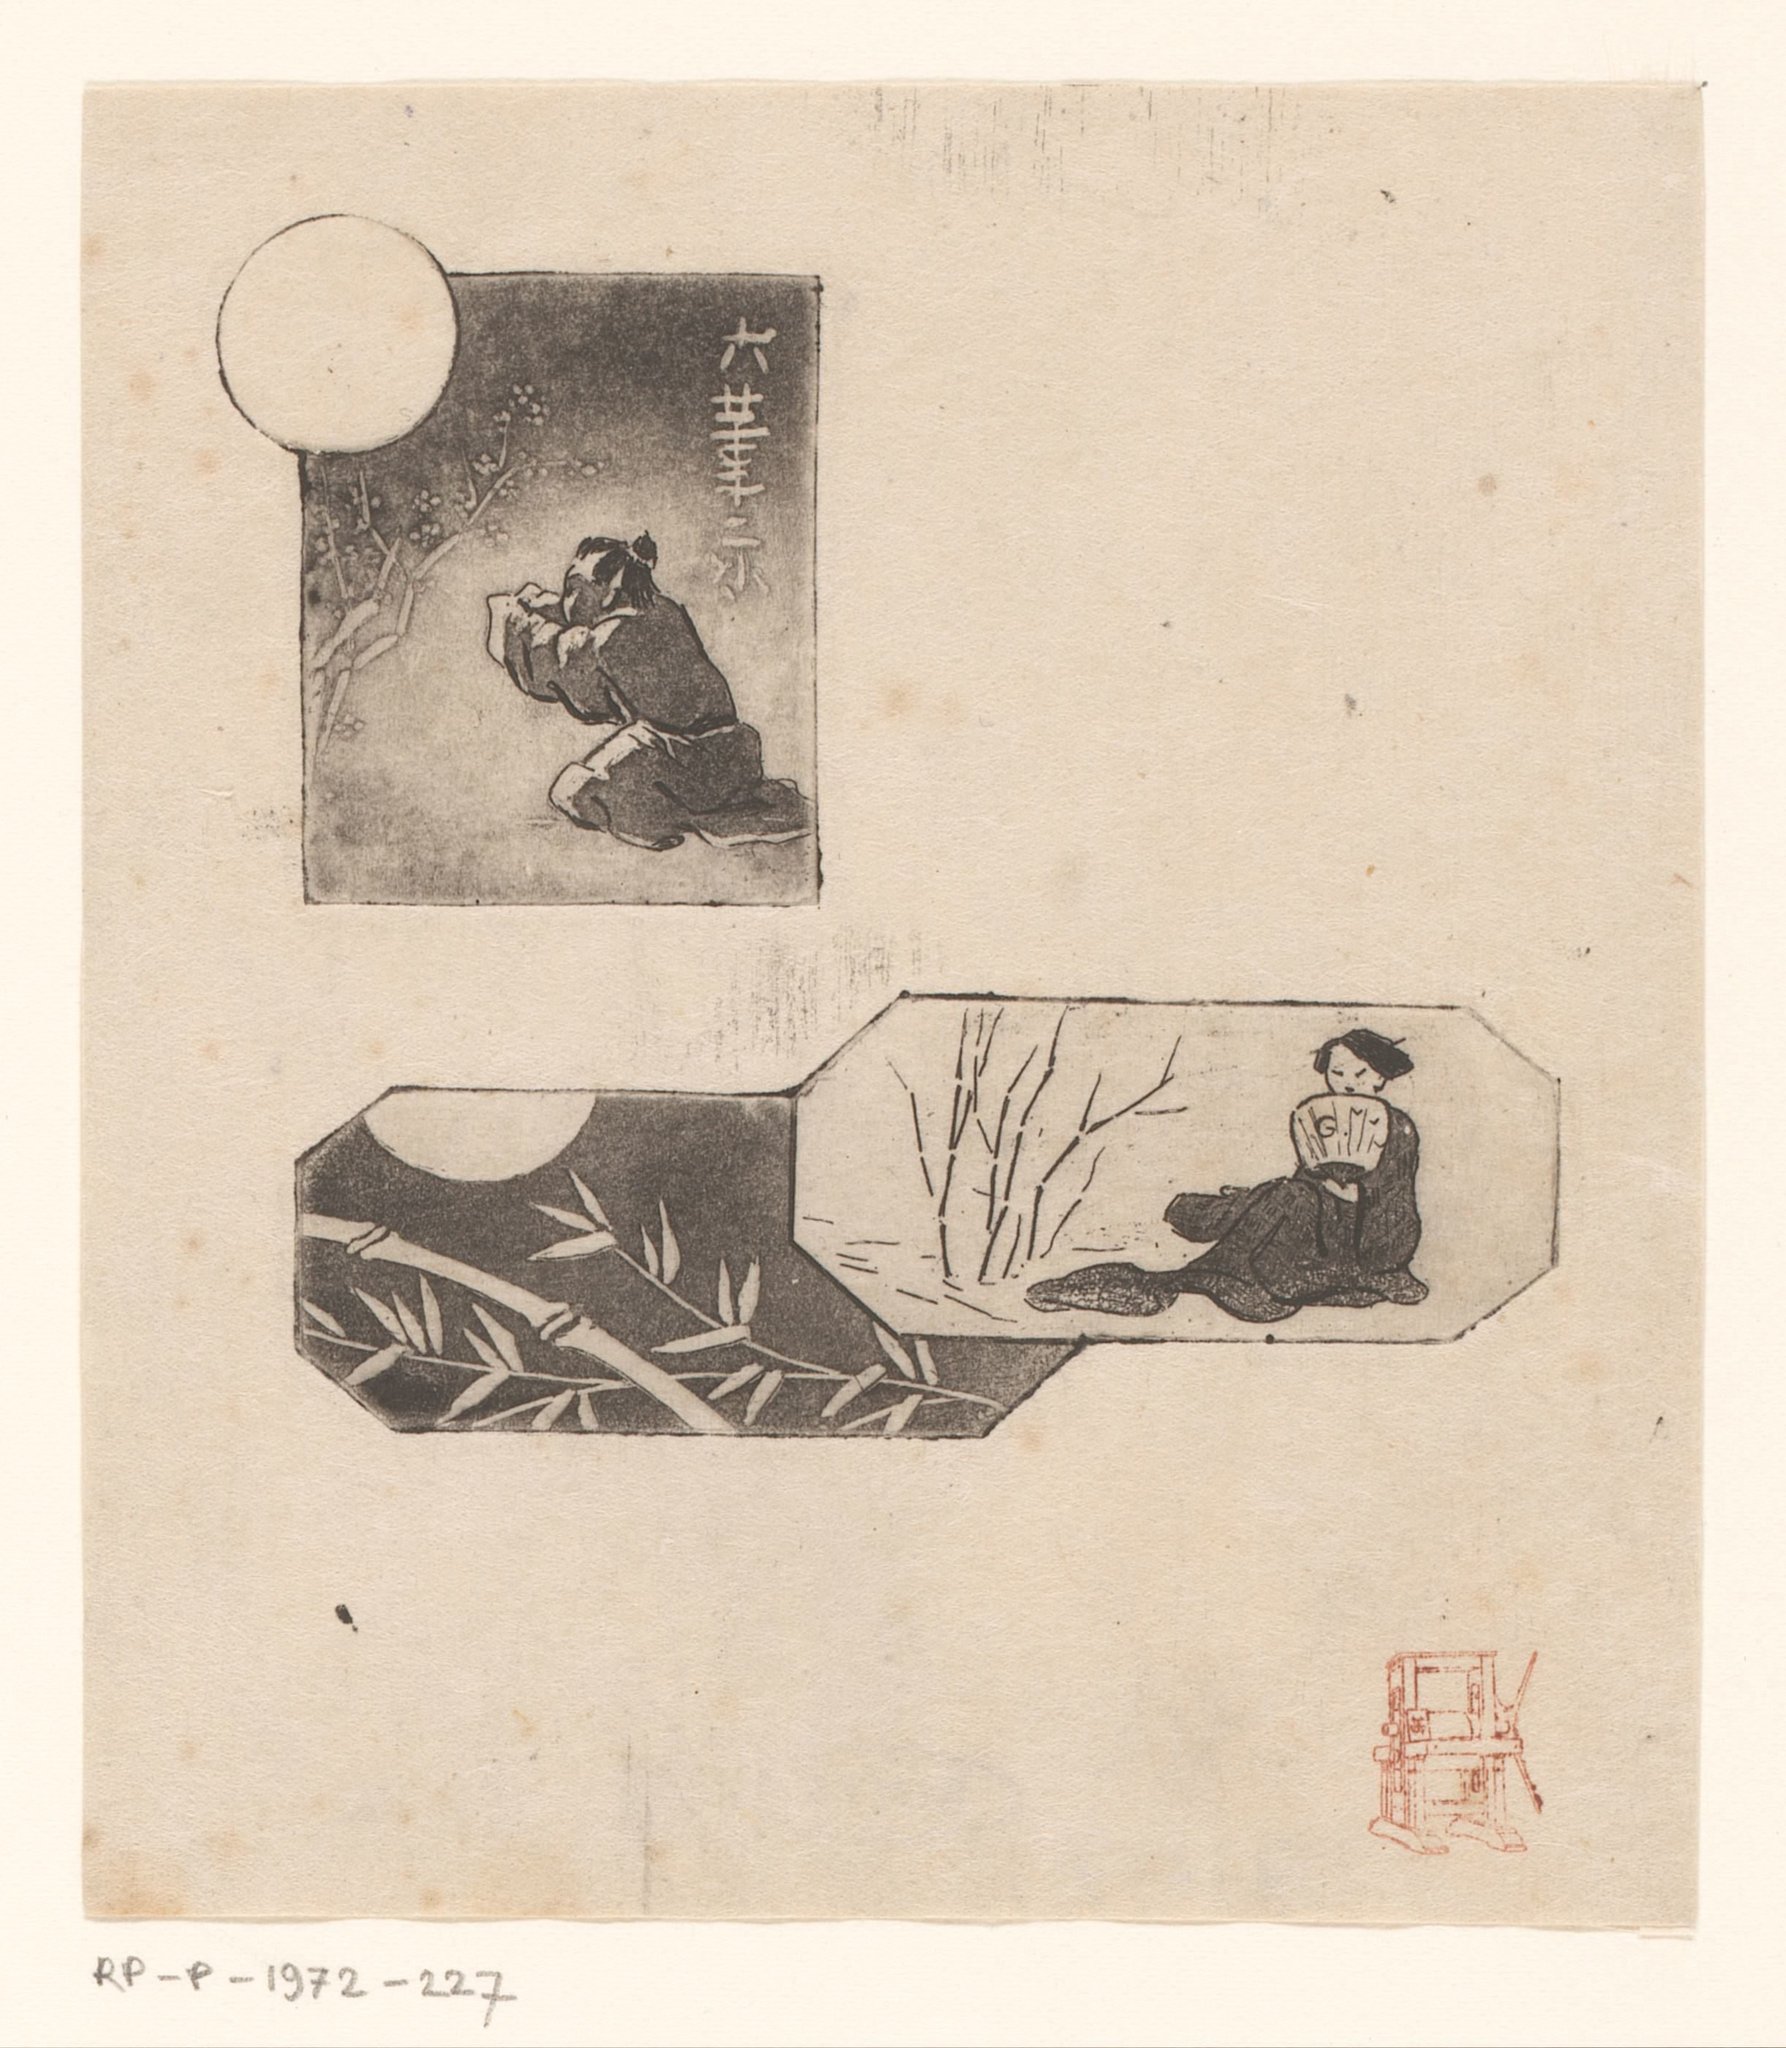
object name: print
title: Compositie met drie Japanse motieven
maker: henri charles guérard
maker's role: print maker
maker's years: 1846-1897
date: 1856-1897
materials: paper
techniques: aquatint, printing, etching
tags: plants (in general), fan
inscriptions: stamp, collector's mark: Lugt 2760, collector's mark: Lugt 2228